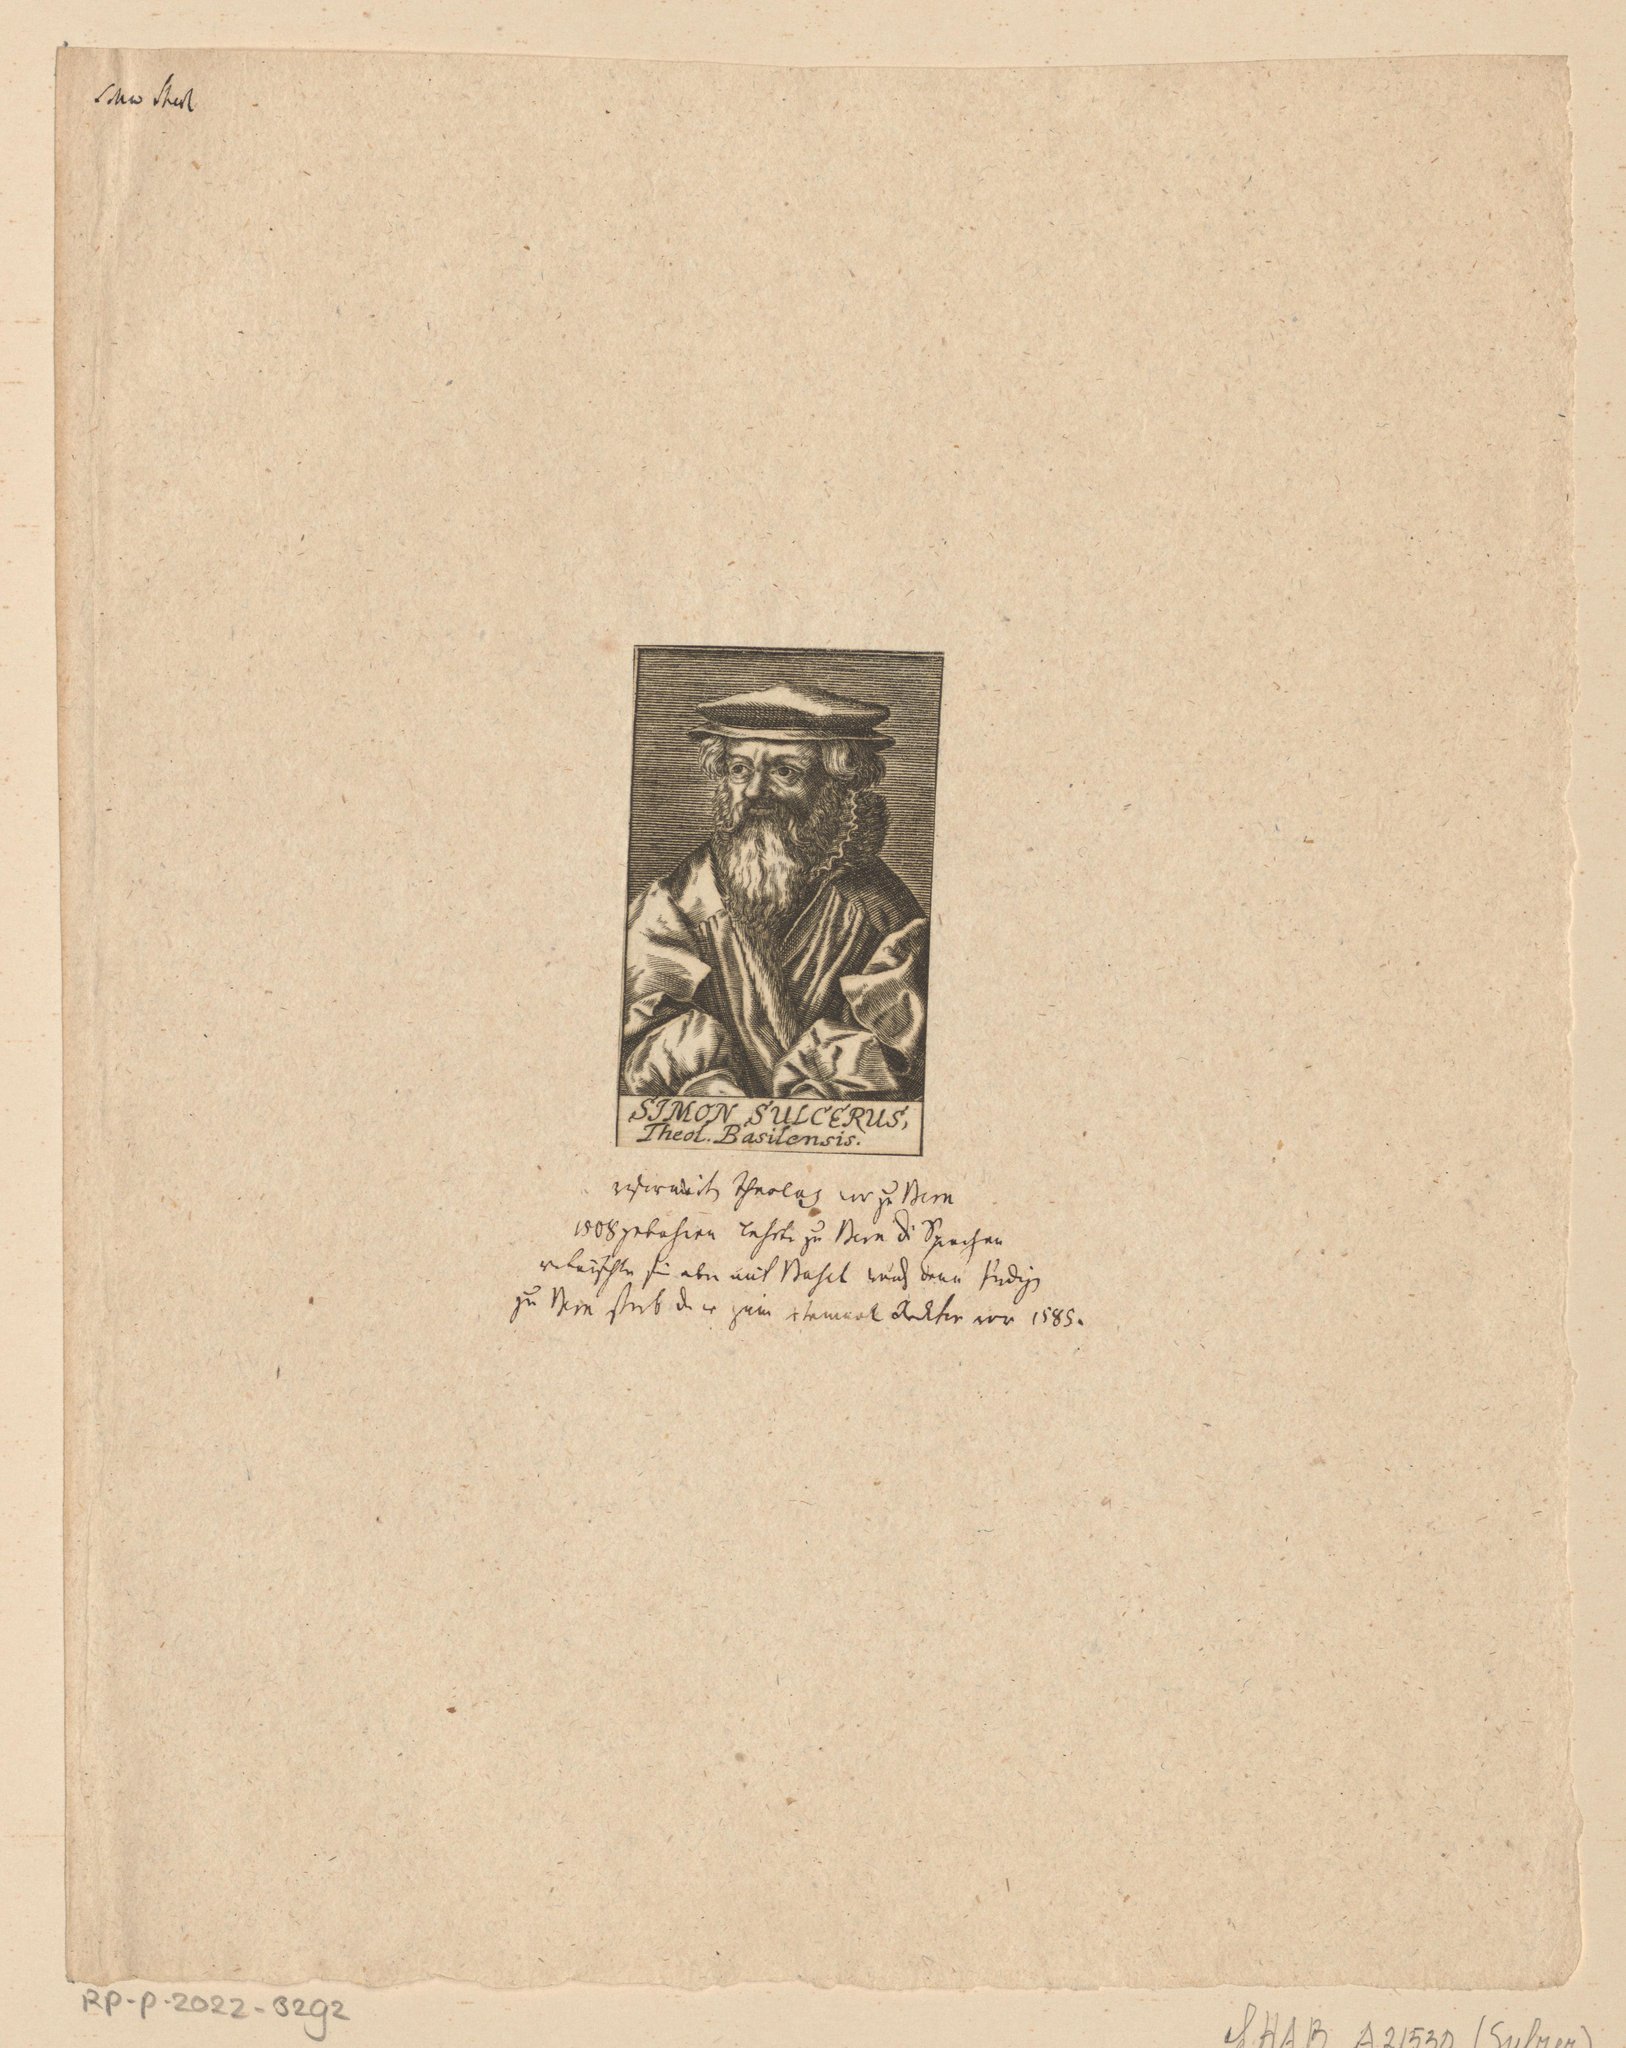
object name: print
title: Portret van Simon Sulzer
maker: Anonymous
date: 1688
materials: paper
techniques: engraving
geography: germany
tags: theologian, historical persons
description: Prent waarschijnlijk uit: Freher, Paul. Theatrum virorum eruditione clarorum. Neurenberg: Johann Hoffmann, 1688.